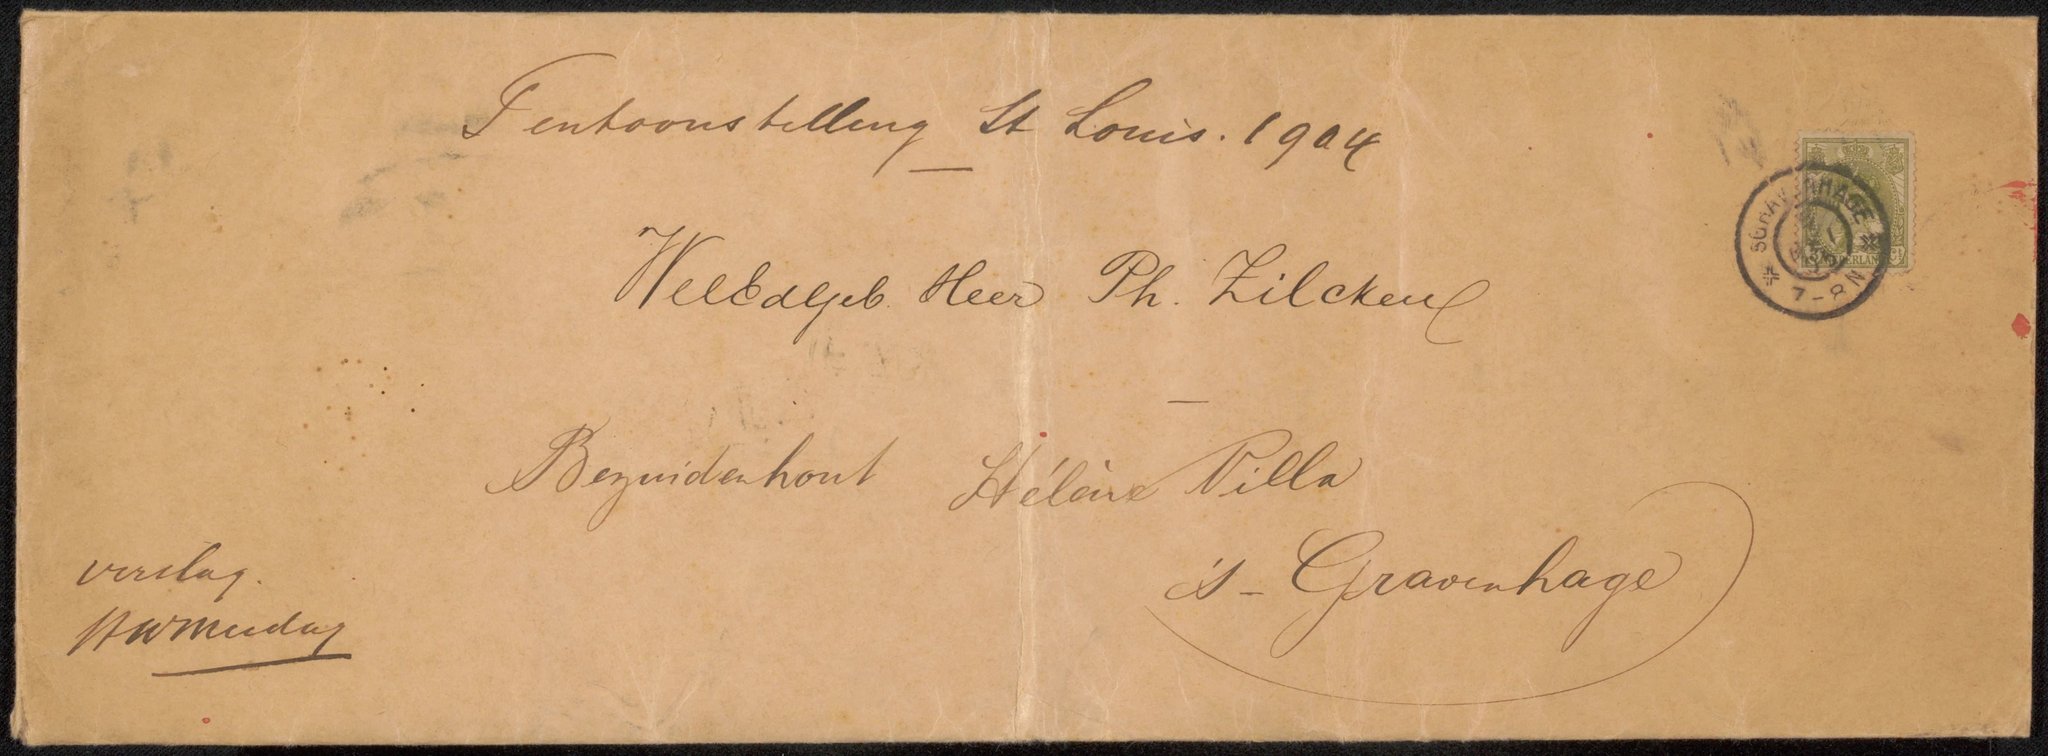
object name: envelope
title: Envelop aan Philip Zilcken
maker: eduard karsen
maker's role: draughtsman, painter, print maker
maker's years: 1860-1941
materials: ink, paper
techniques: pen, writing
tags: painter, print maker, draughtsman, hendrik willem mesdag, philip zilcken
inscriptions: collector's mark: ‘RPK’